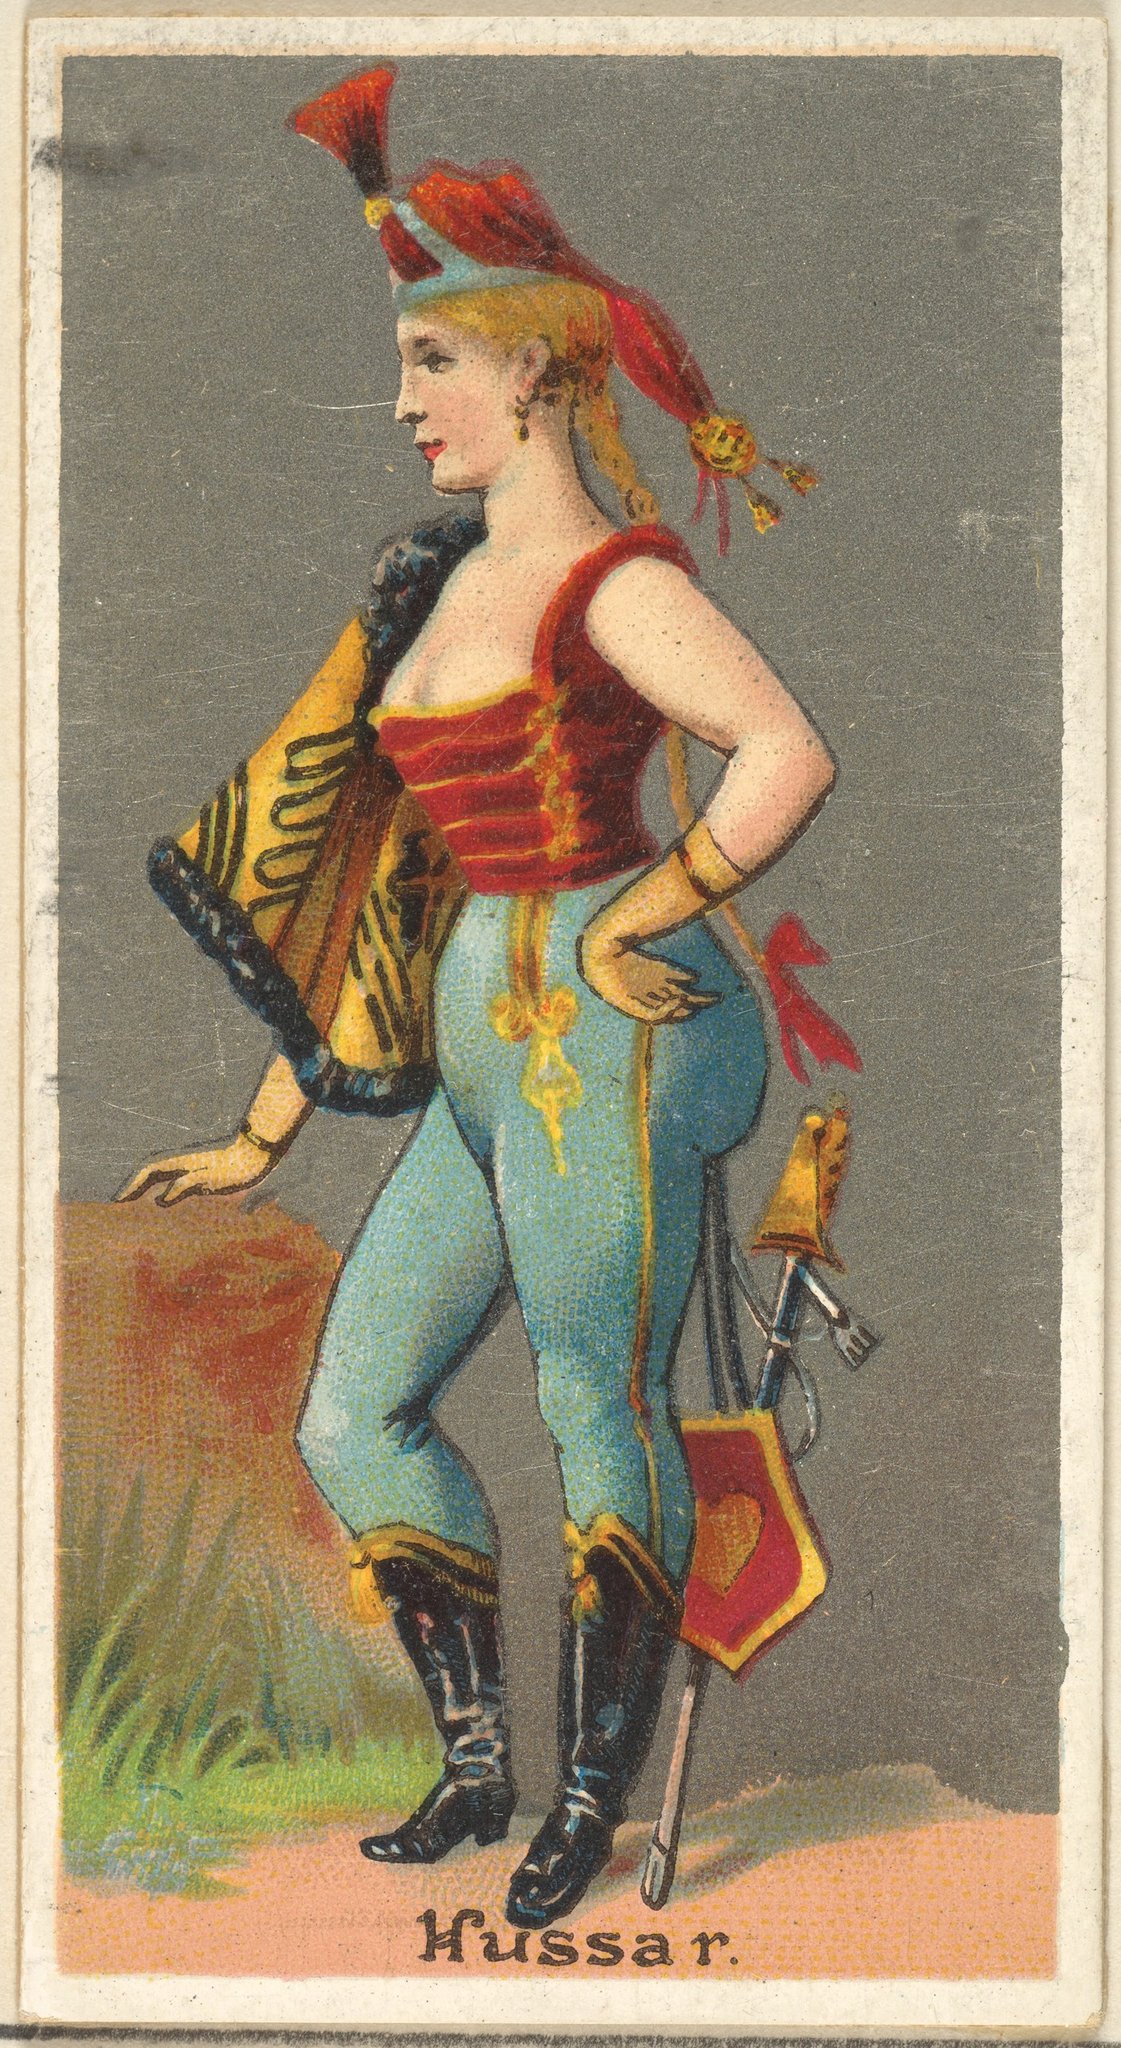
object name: print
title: Hussar, from the Occupations for Women series (N166) for Old Judge and Dogs Head Cigarettes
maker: goodwin & company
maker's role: publisher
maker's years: 1850-1950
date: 1887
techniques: color lithograph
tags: soldiers,profiles,women